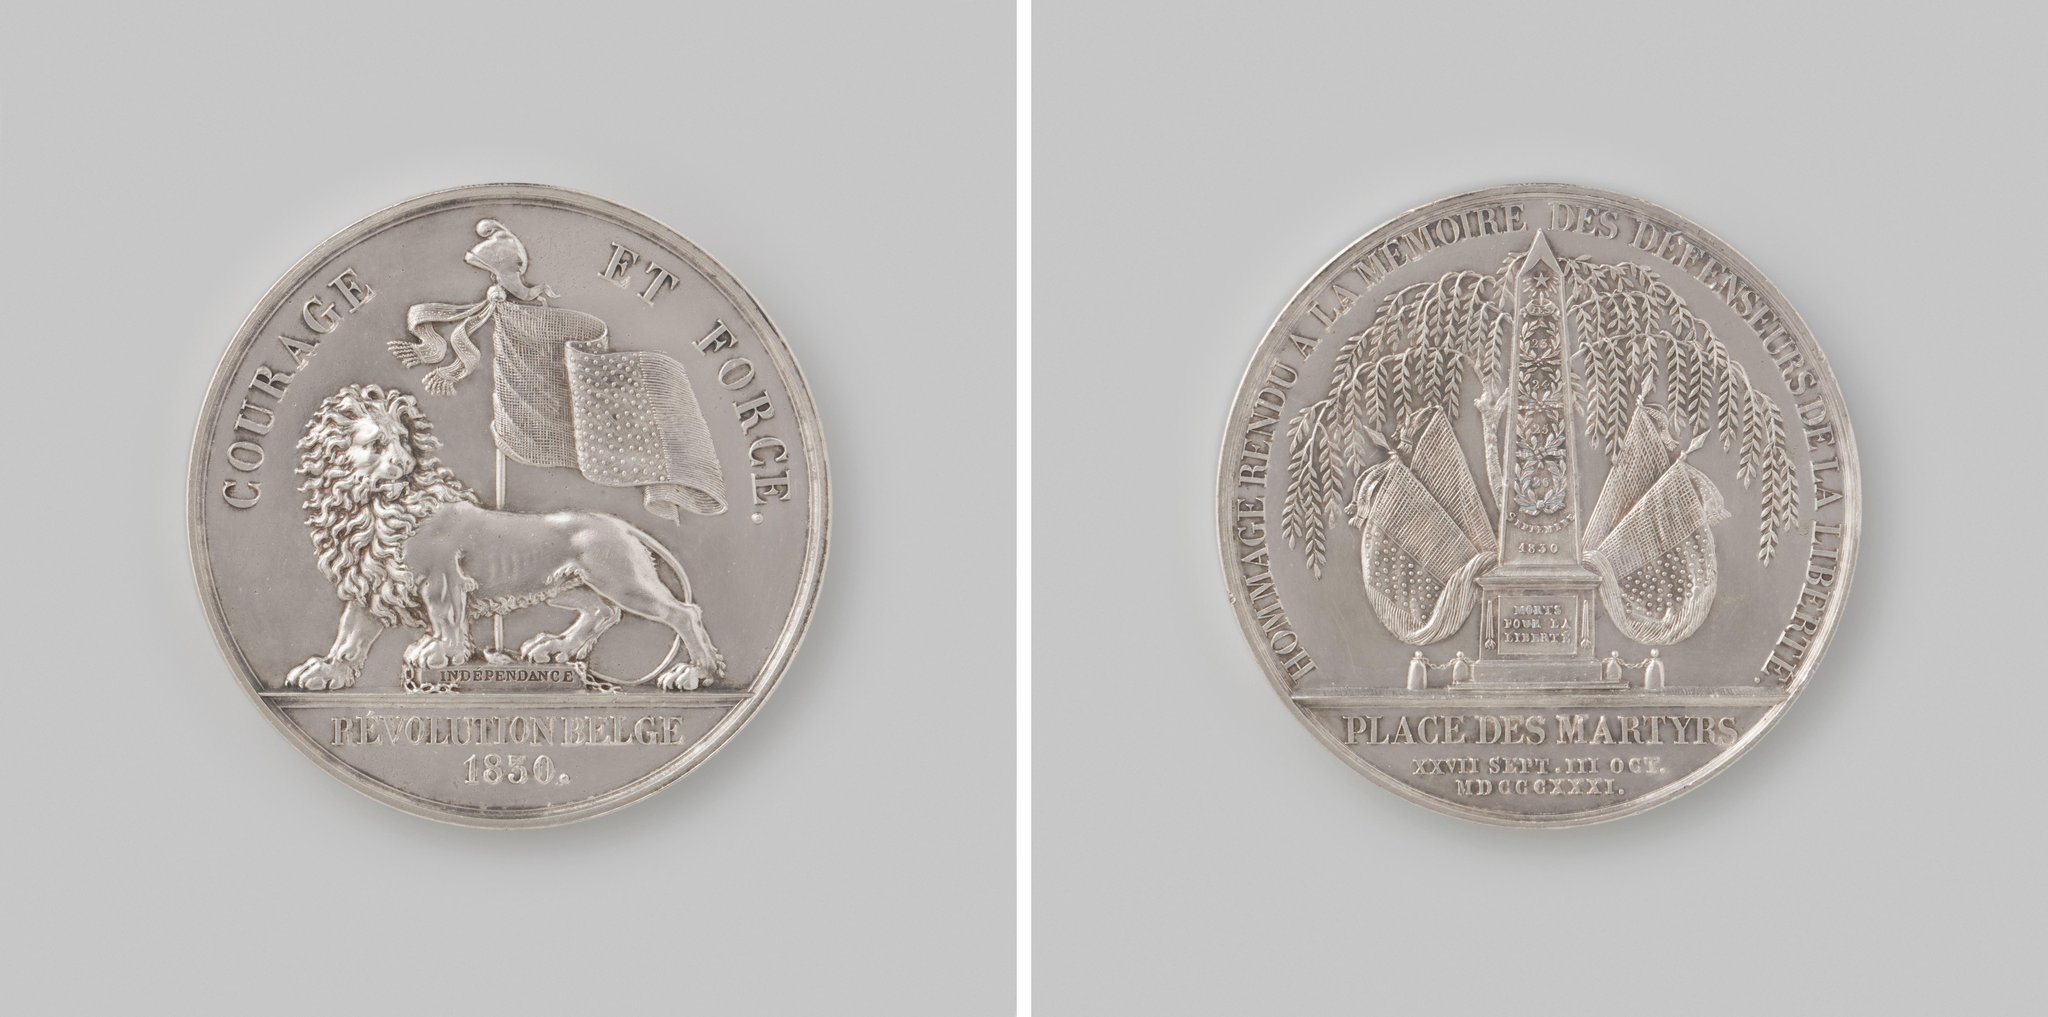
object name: history medal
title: Eerste verjaardag van de Belgische revolutie op de Place des Martyres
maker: m. borrel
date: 1831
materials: silver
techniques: striking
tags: laeken, leopold i (koning der belgen)